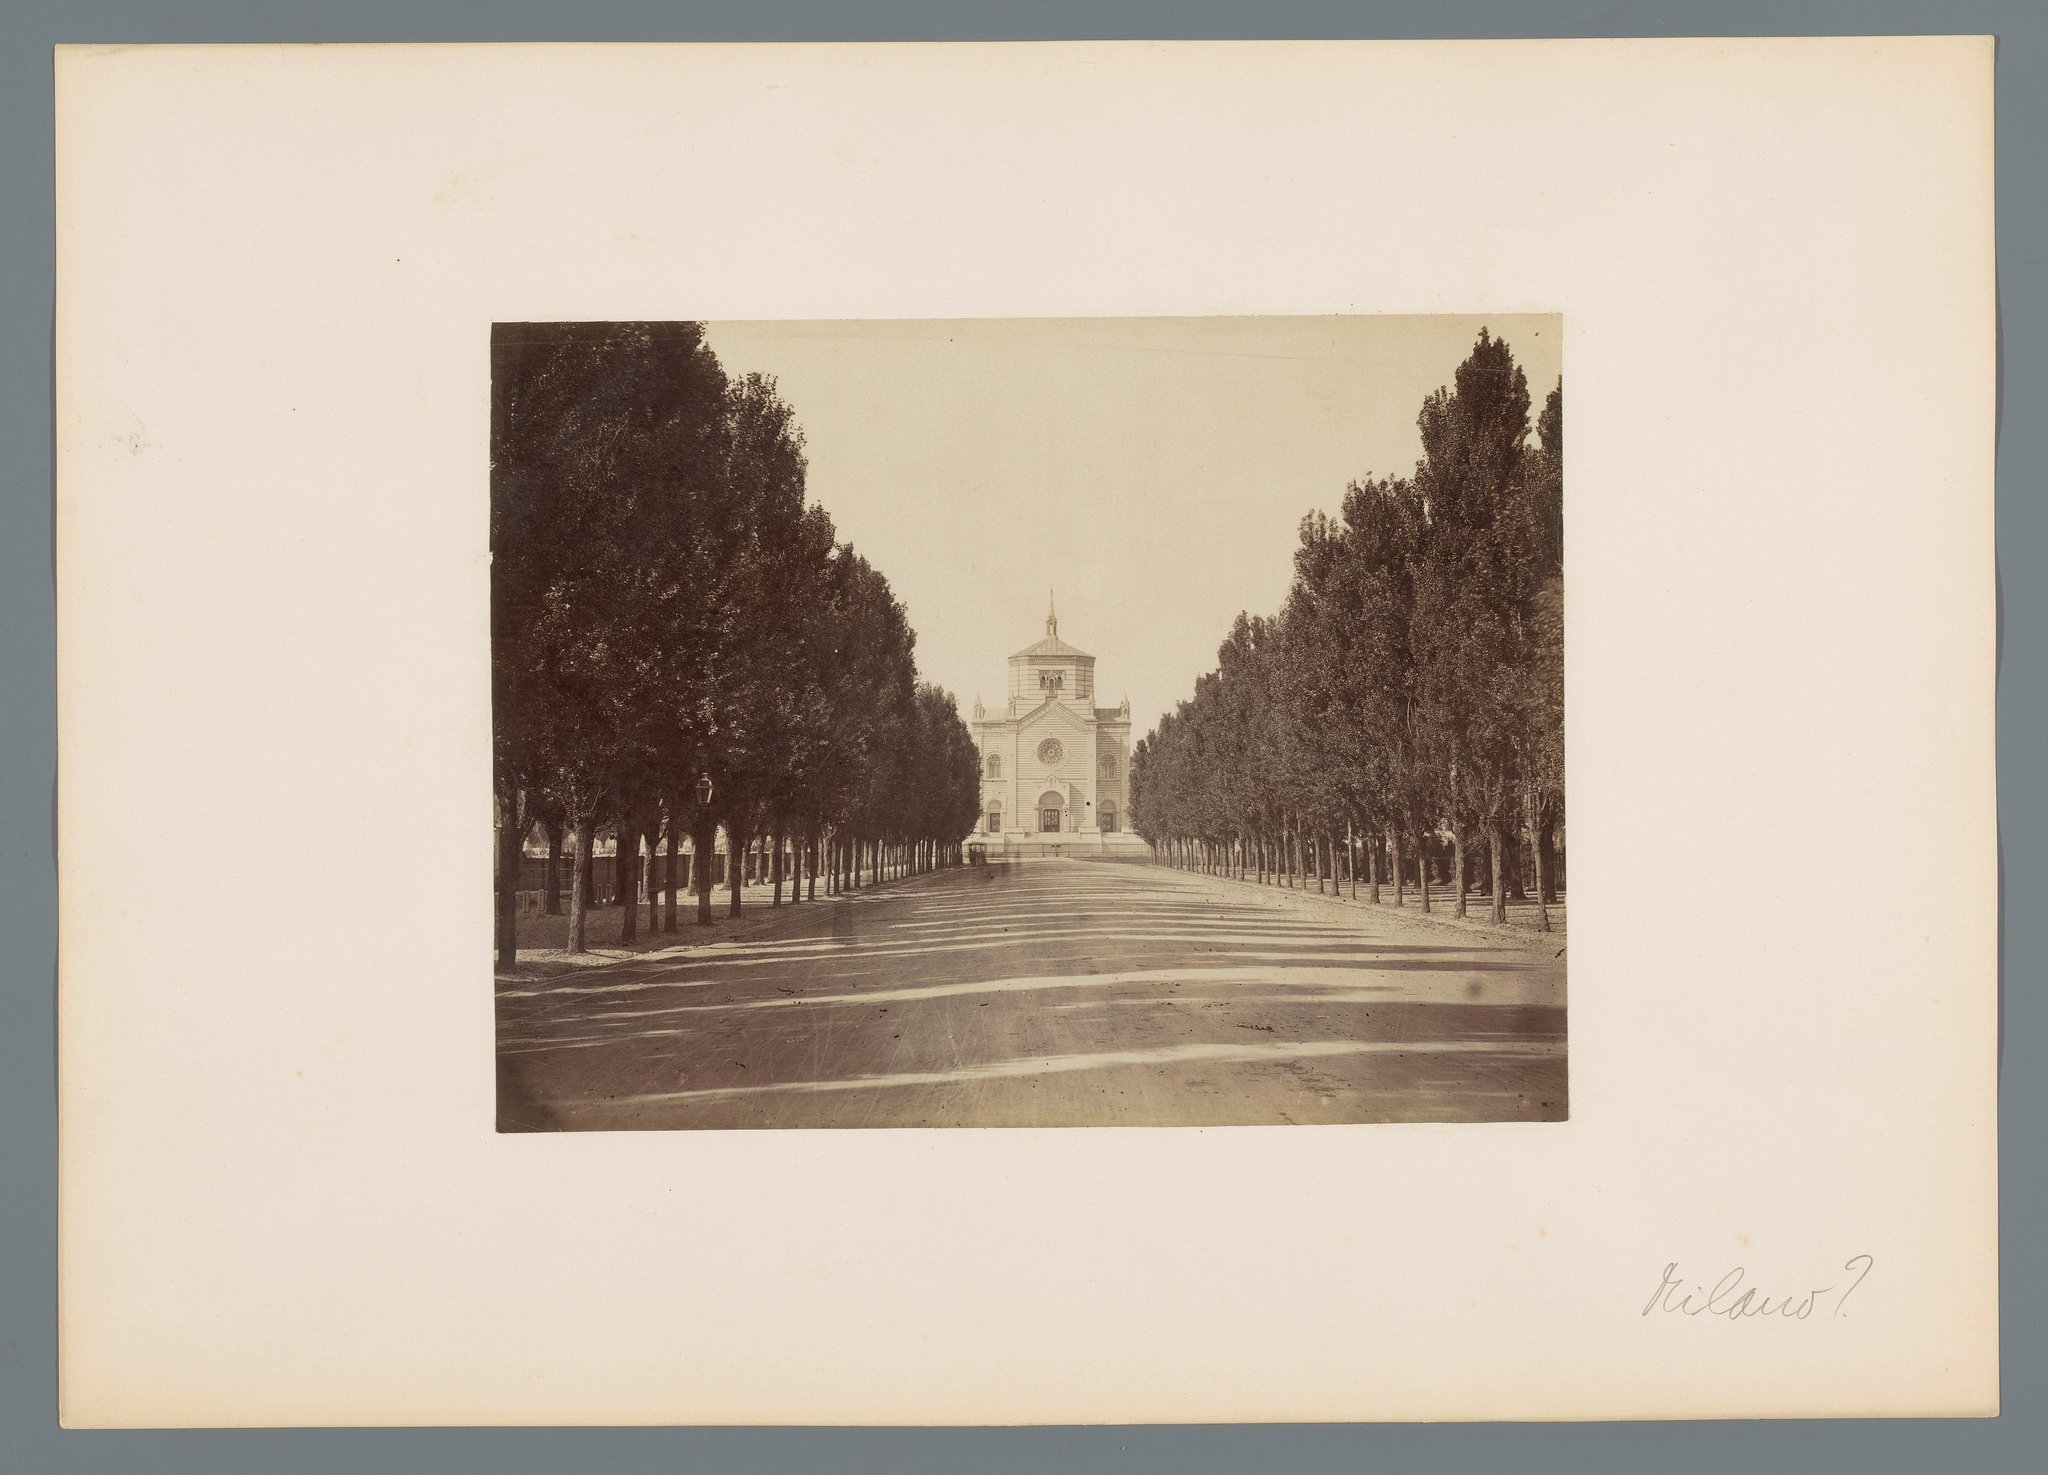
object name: photograph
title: Gebouw op het Cimitero Monumentale te Milaan, Italië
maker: Anonymous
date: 1851-1900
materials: cardboard, paper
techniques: albumen print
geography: milan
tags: church (exterior), churchyard, cemetery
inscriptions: inscription: ‘Milano?’